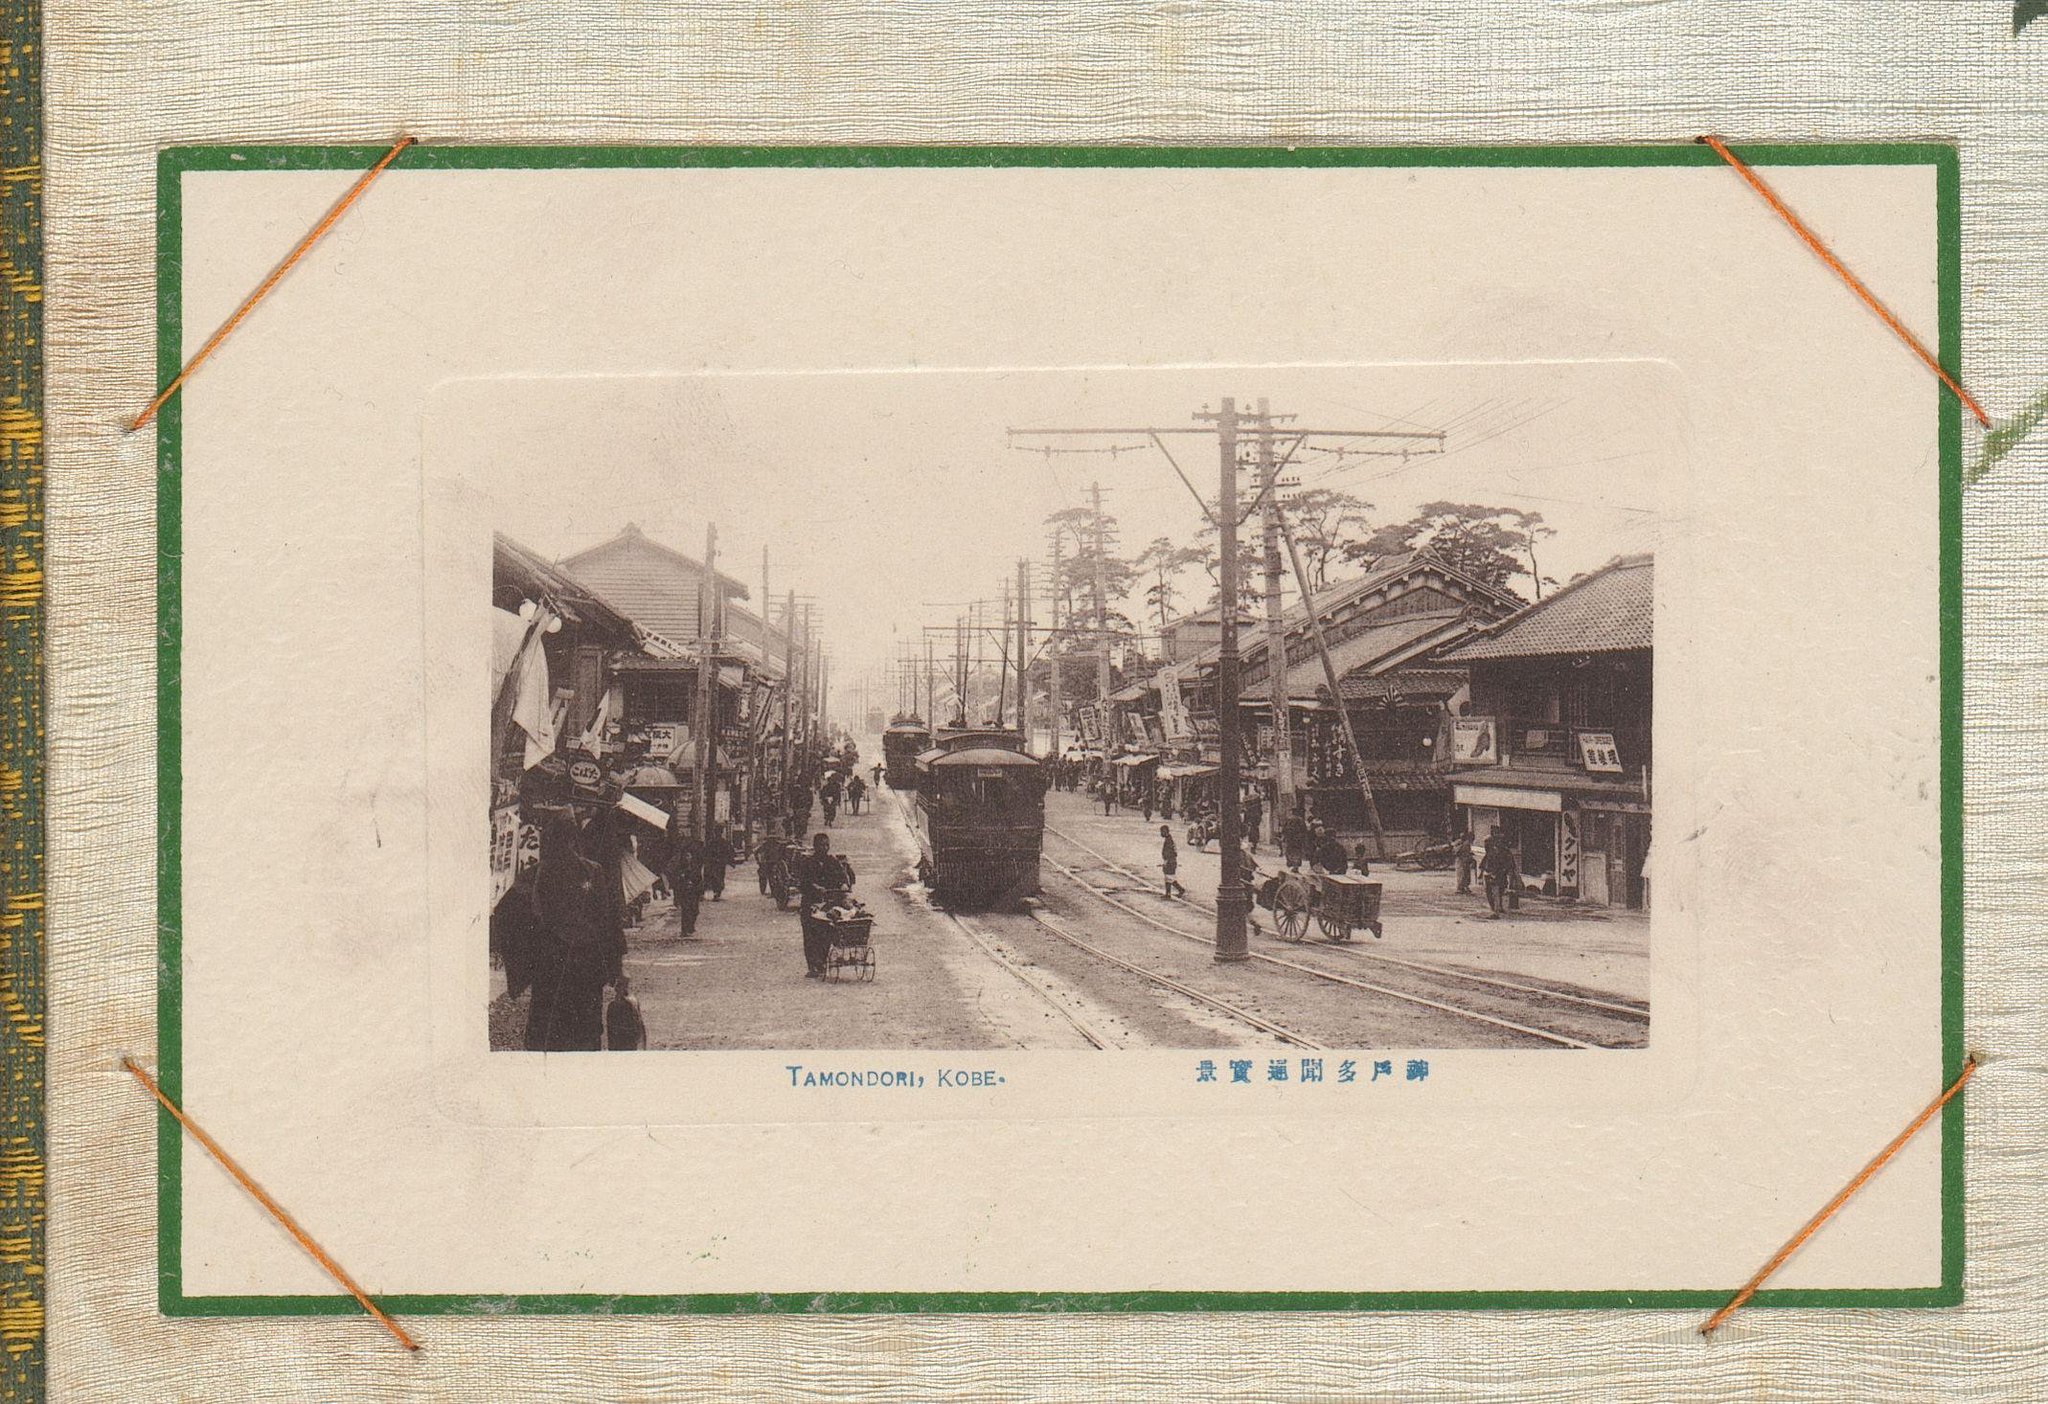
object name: photomechanical print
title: Tamondori, Kobe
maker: Anonymous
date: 1900-1920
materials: paper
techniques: photograph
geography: kobe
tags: hand-cart, tramway, tram, street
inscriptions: title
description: Deze prent maakt deel uit van een album.